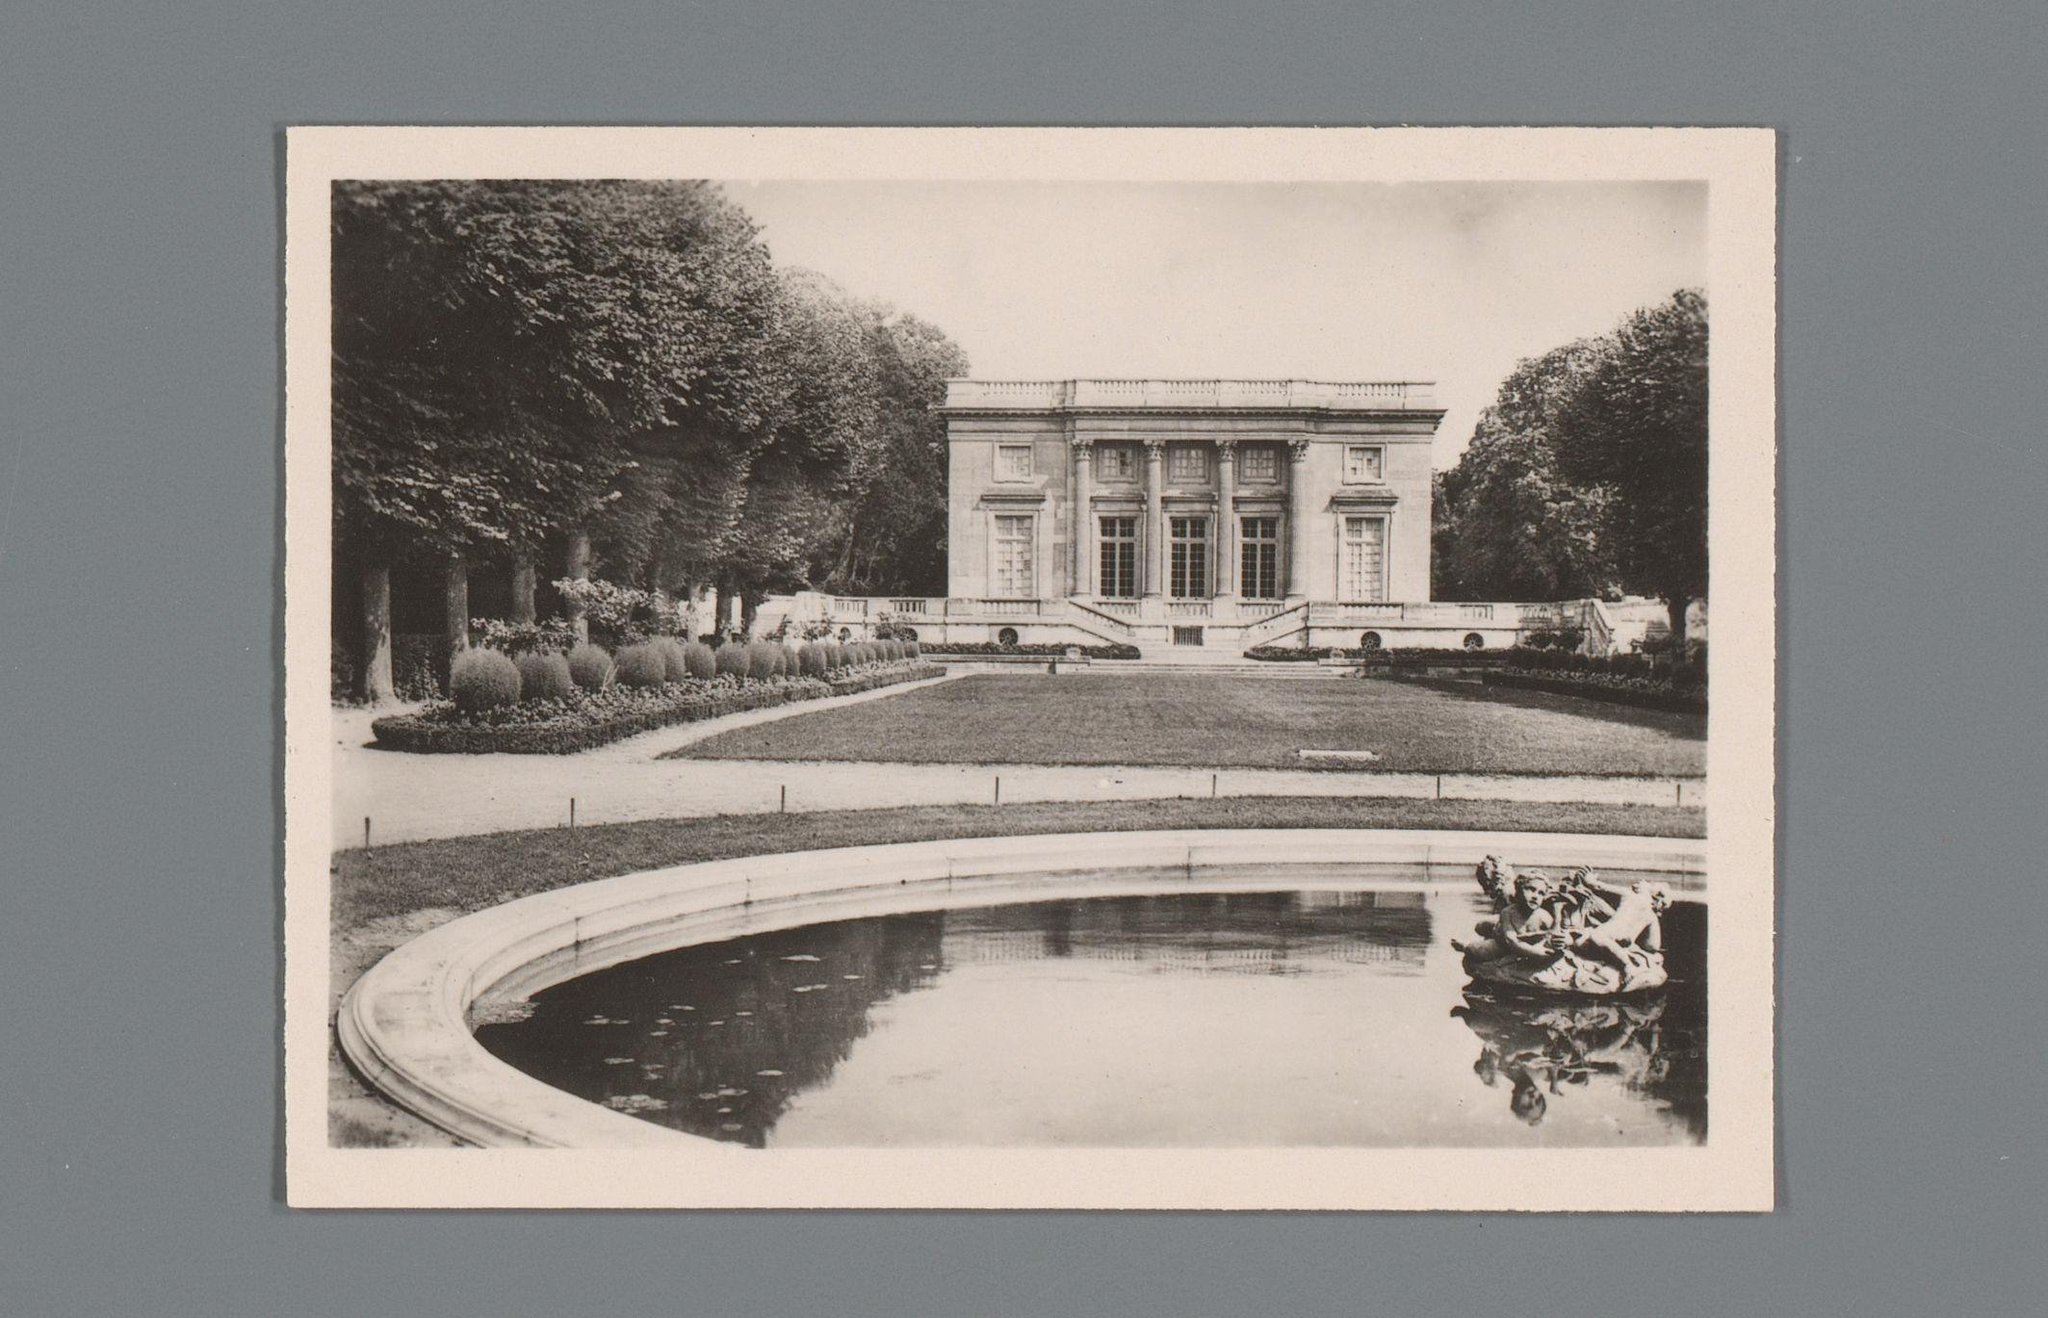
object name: photograph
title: Klein Trianon in de Franse tuin in het Kasteel van Versailles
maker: Anonymous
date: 1900-1920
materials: paper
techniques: gelatin silver print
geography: versailles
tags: palace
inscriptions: number: ‘15’